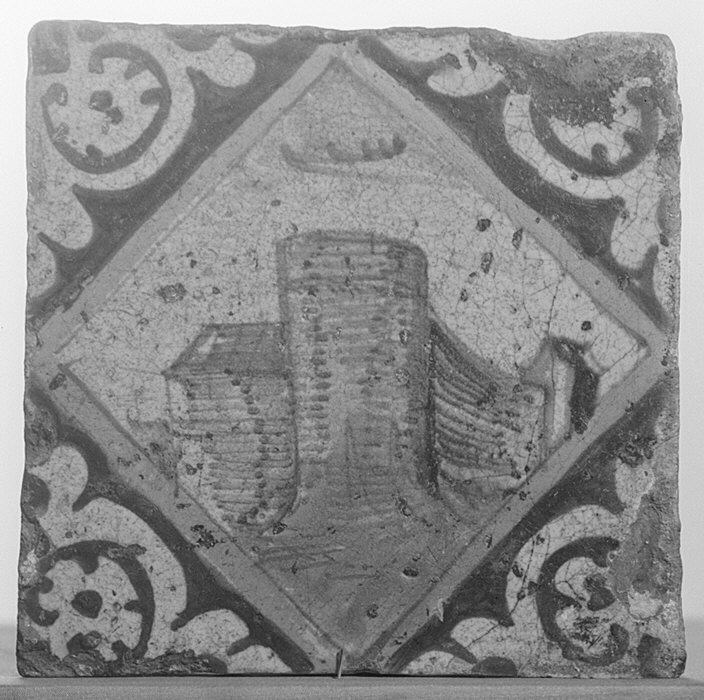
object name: tile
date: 1580-1625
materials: earthenware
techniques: glazing